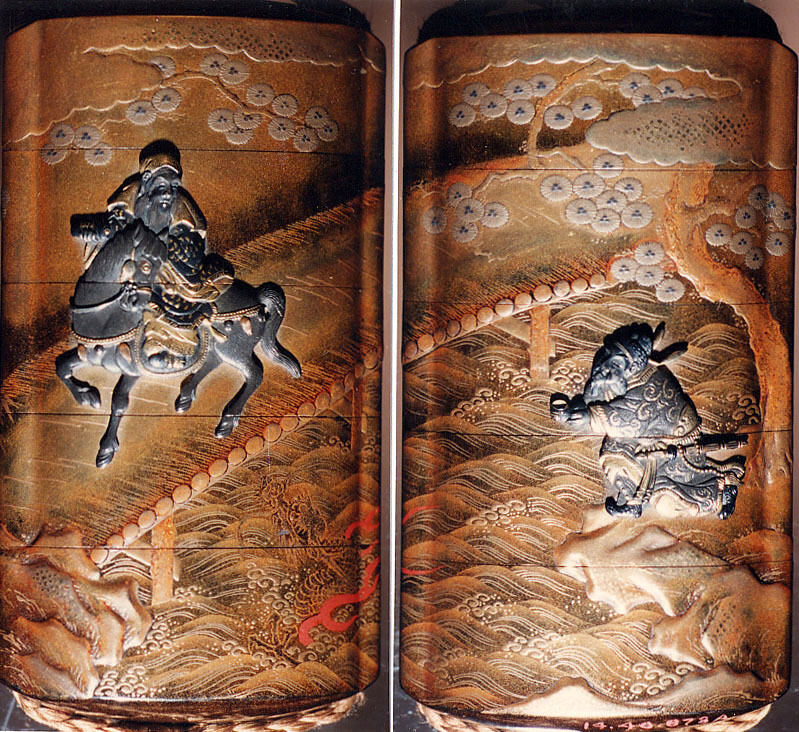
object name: inrō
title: Case (Inrō) with Design of Chōryō and Kōsekikō at Kahi Bridge in China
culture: japanese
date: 1801-1900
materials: gold, lacquer, metal, silver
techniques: fundame, hiramakie, inlay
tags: bridges,men,horses